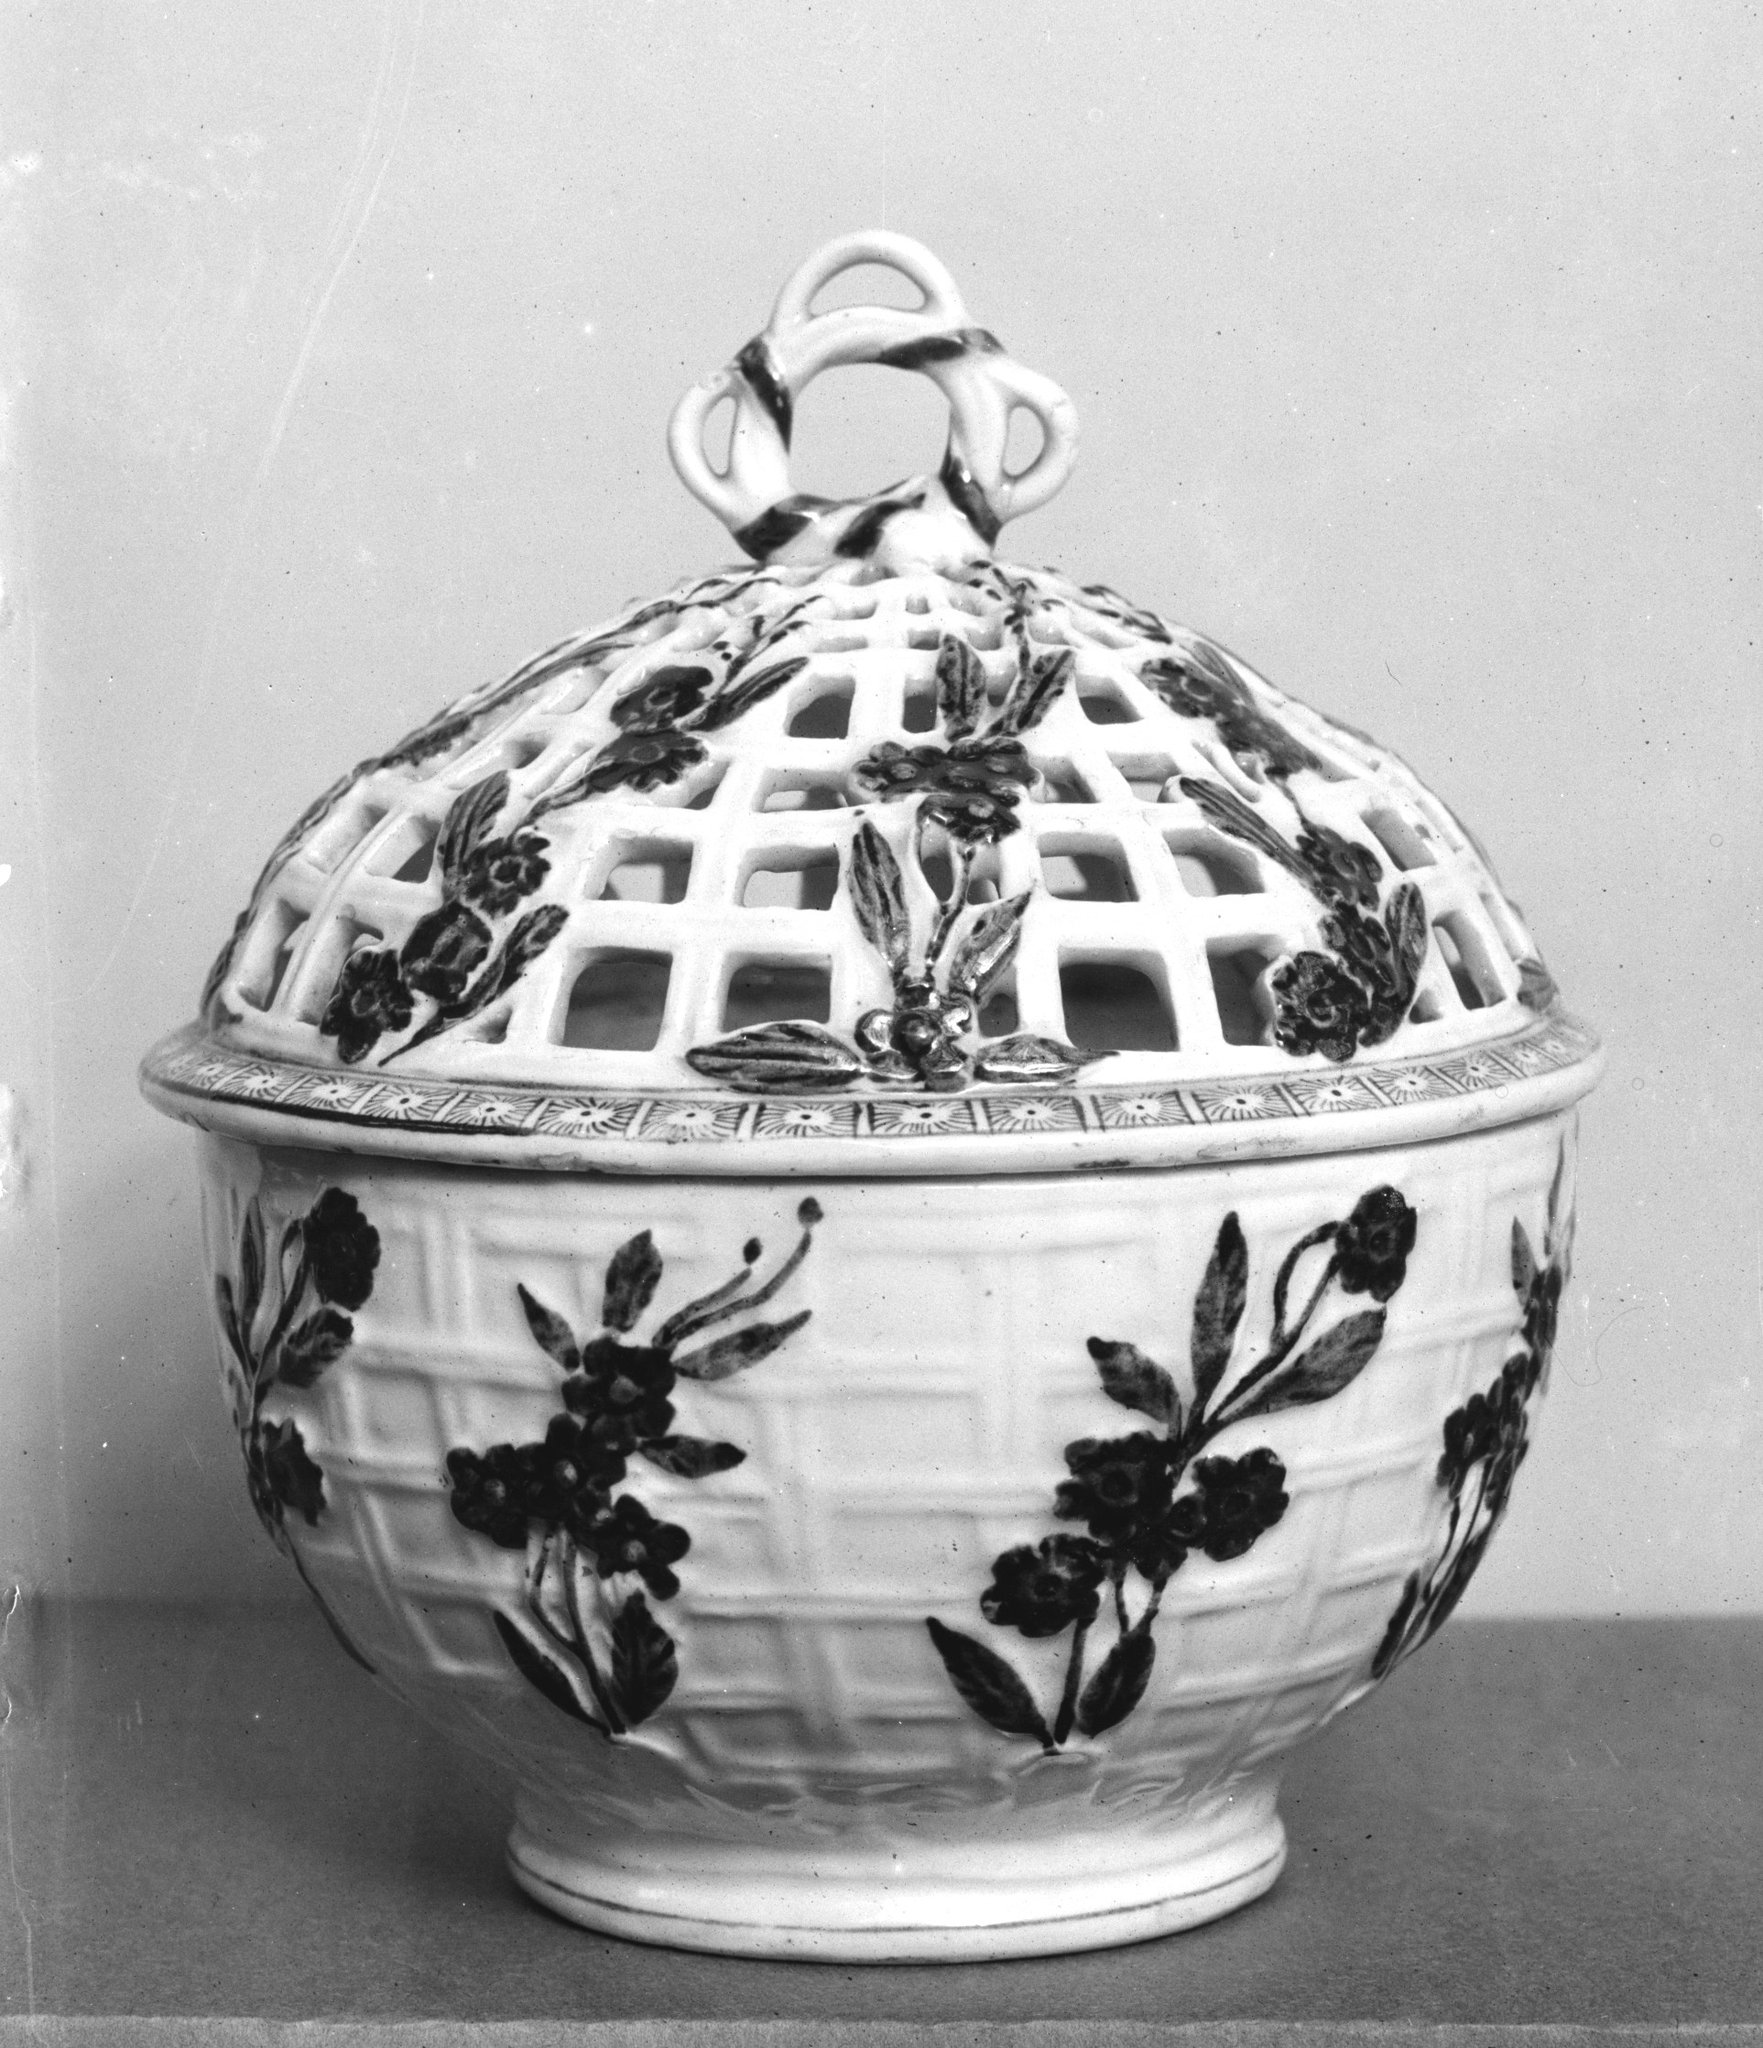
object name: bowl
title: Chestnut Bowl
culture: british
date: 1730-1800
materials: porcelain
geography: england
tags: flowers